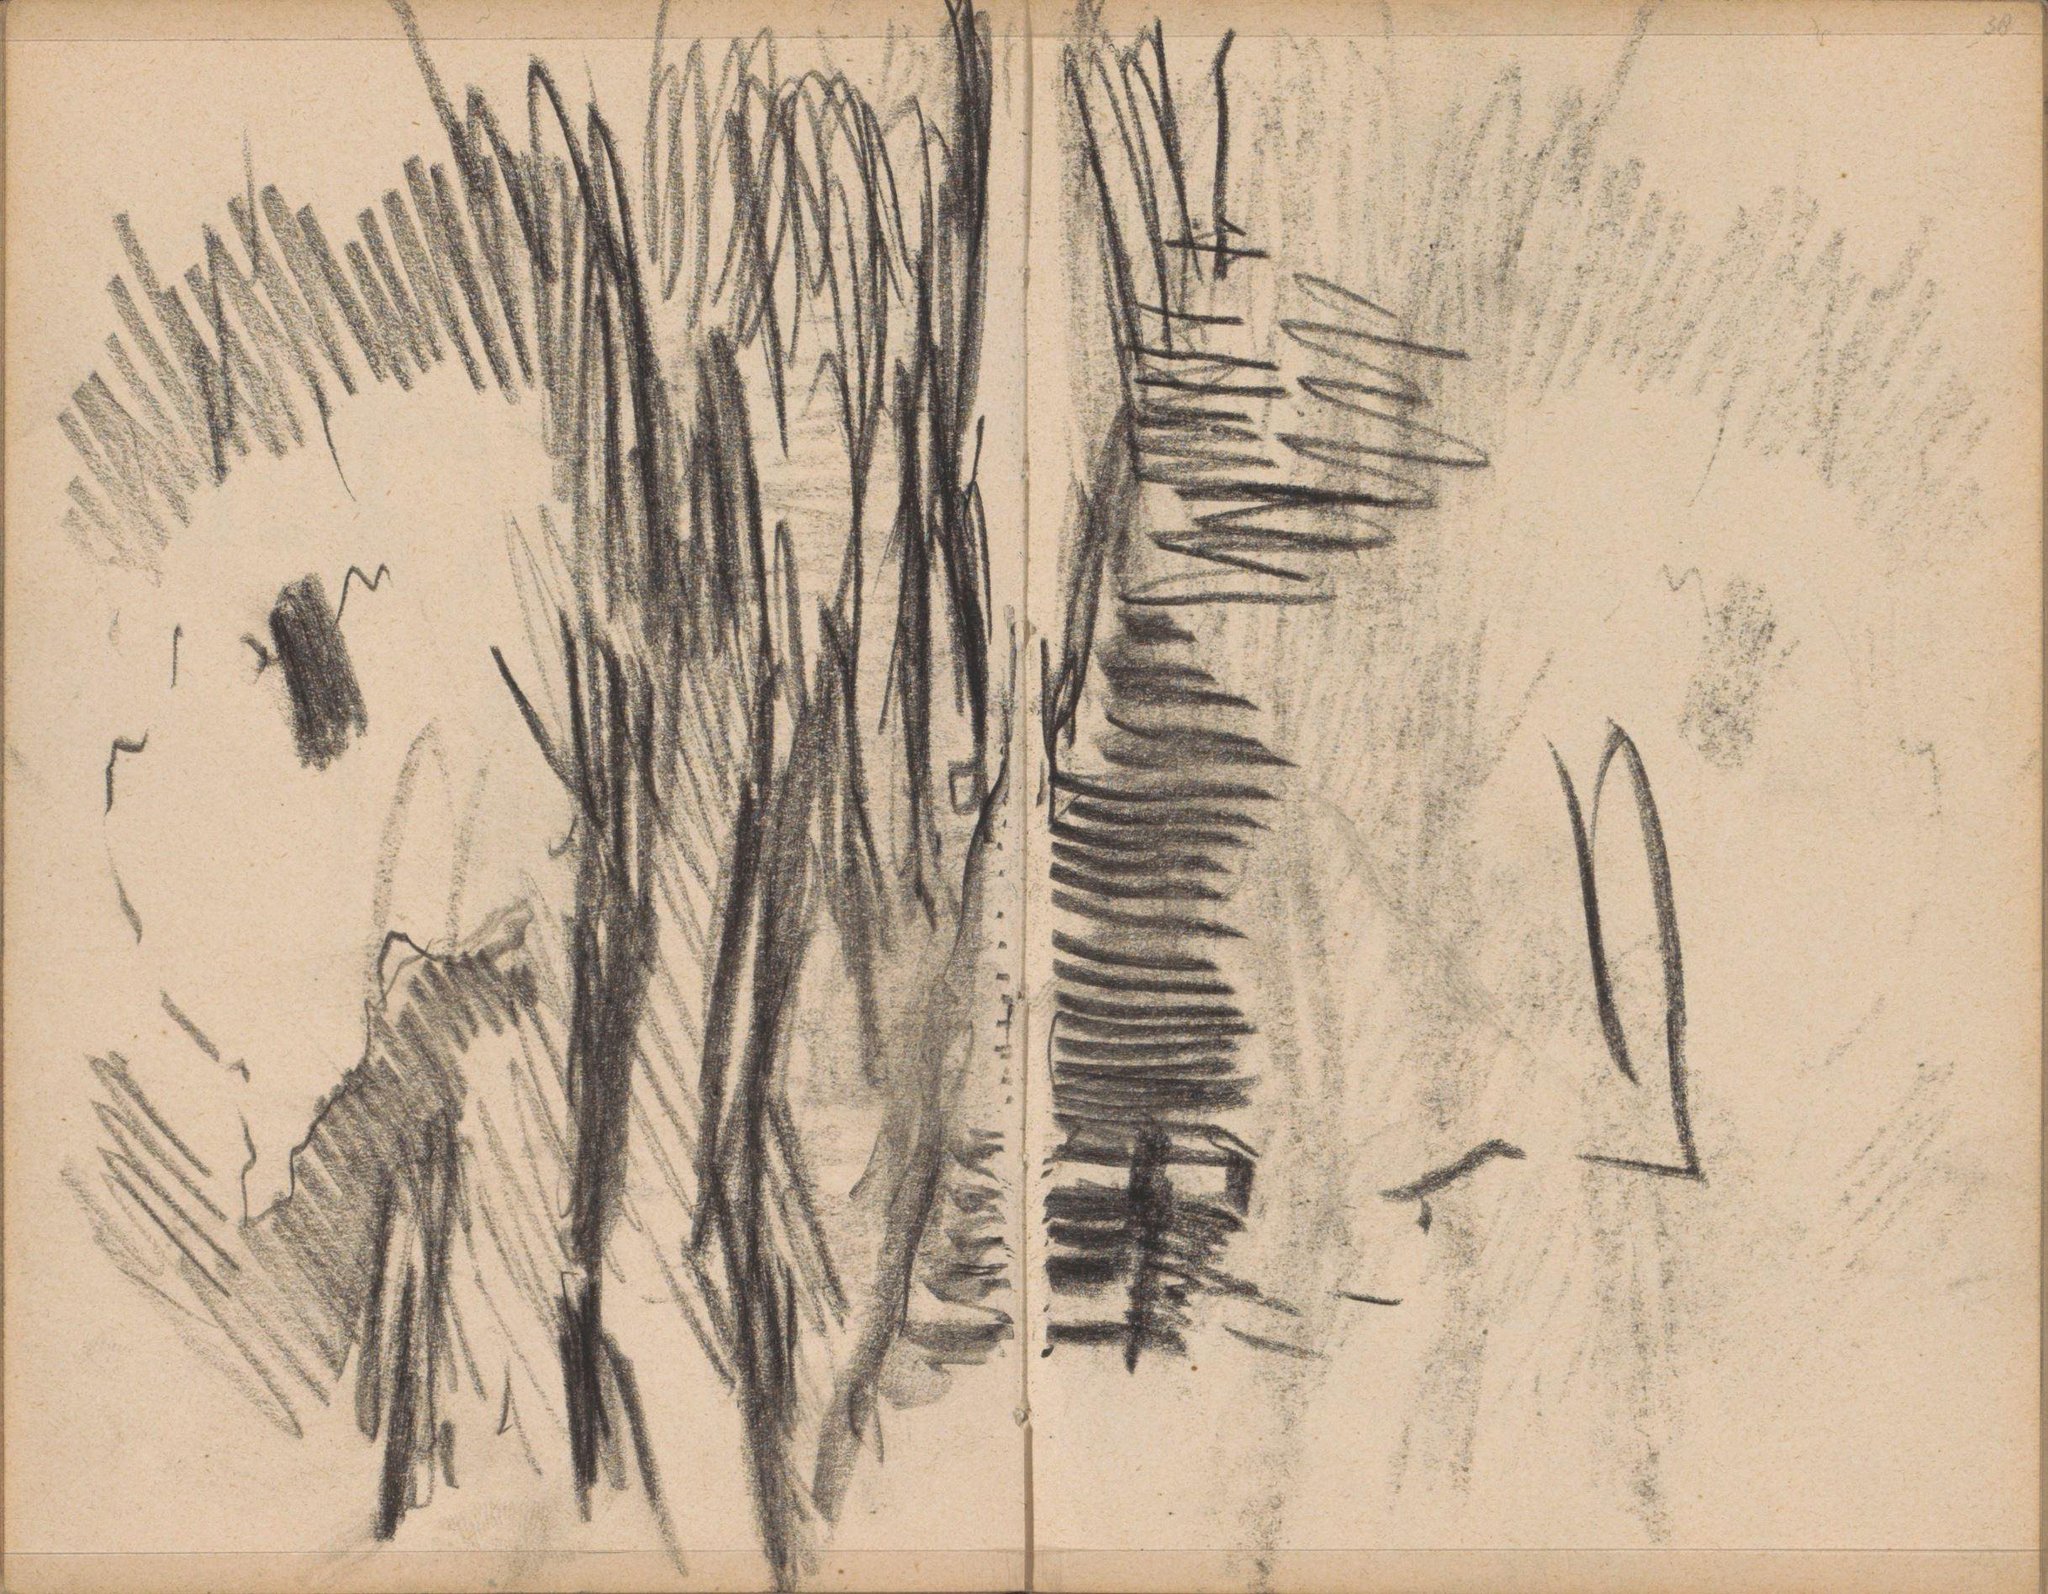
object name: sketchbook leaf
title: Landschap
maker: george hendrik breitner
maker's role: draughtsman, painter, print maker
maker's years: 1857-1923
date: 1907-1909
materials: chalk, paper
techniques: stumping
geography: amsterdam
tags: landscapes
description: Landschap. Pagina 37 en pagina 38 uit een schetsboek met 46 bladen vervaardigd te Antwerpen, Gent en Amsterdam.